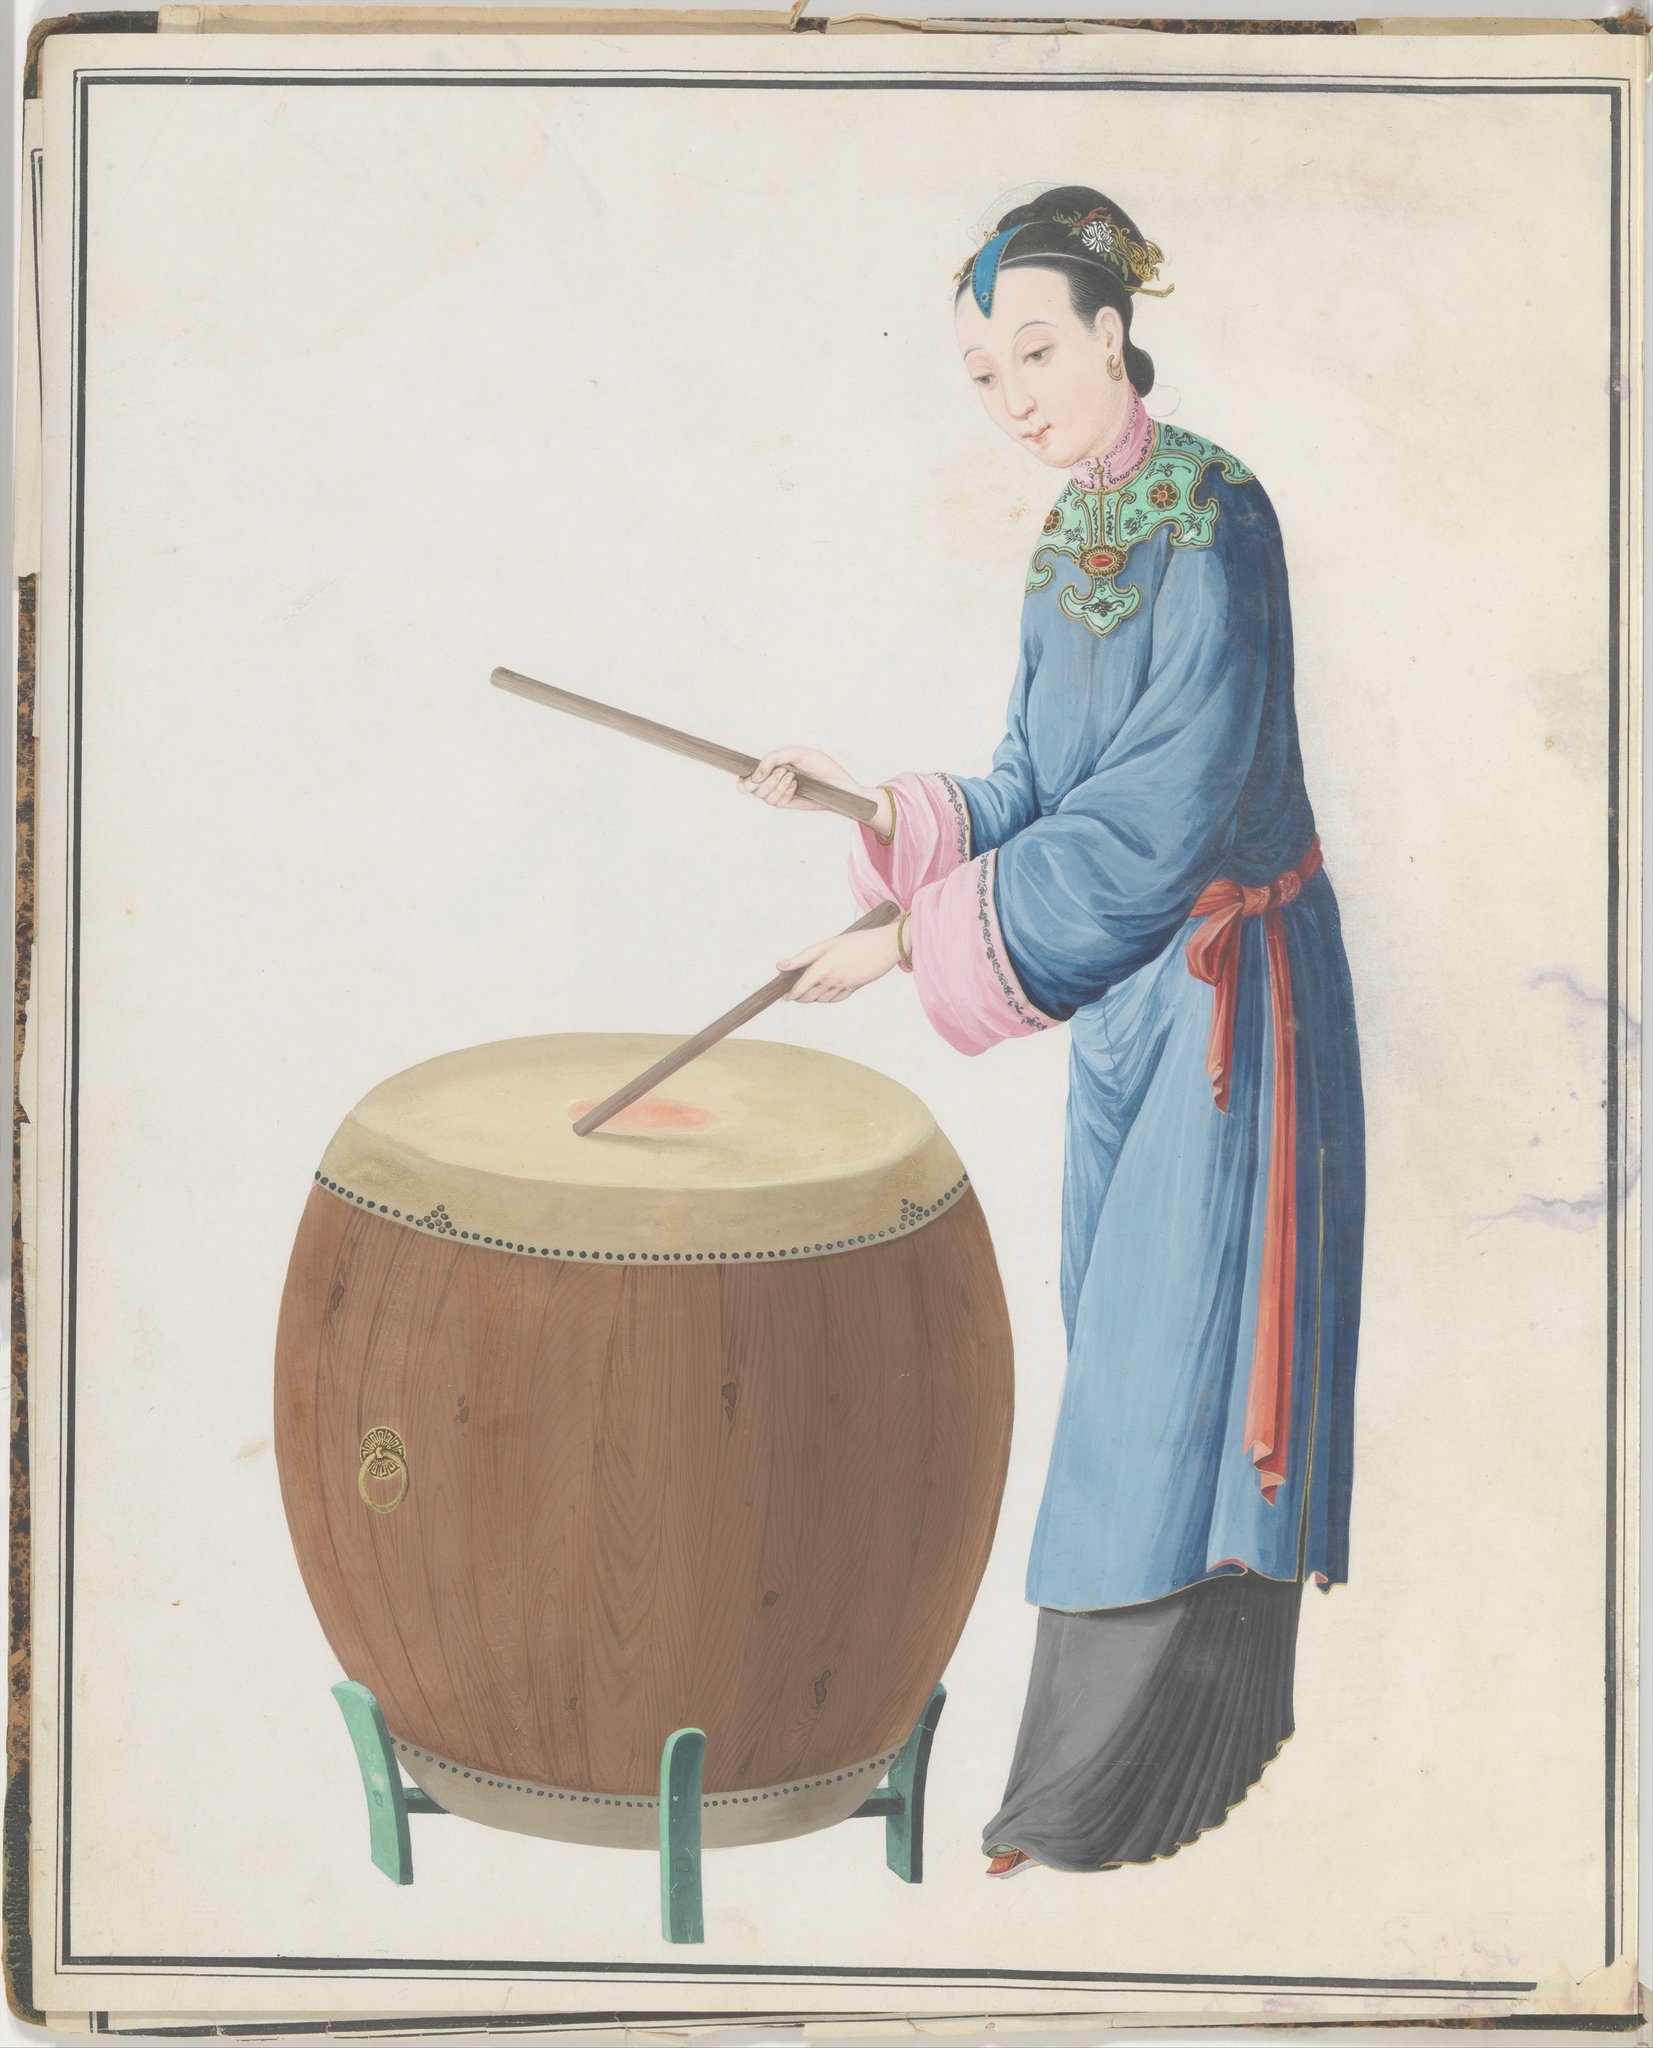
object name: watercolor of musician playing jingu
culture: chinese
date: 1767-1800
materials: paper, watercolor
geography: china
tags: musical instruments,women,musicians